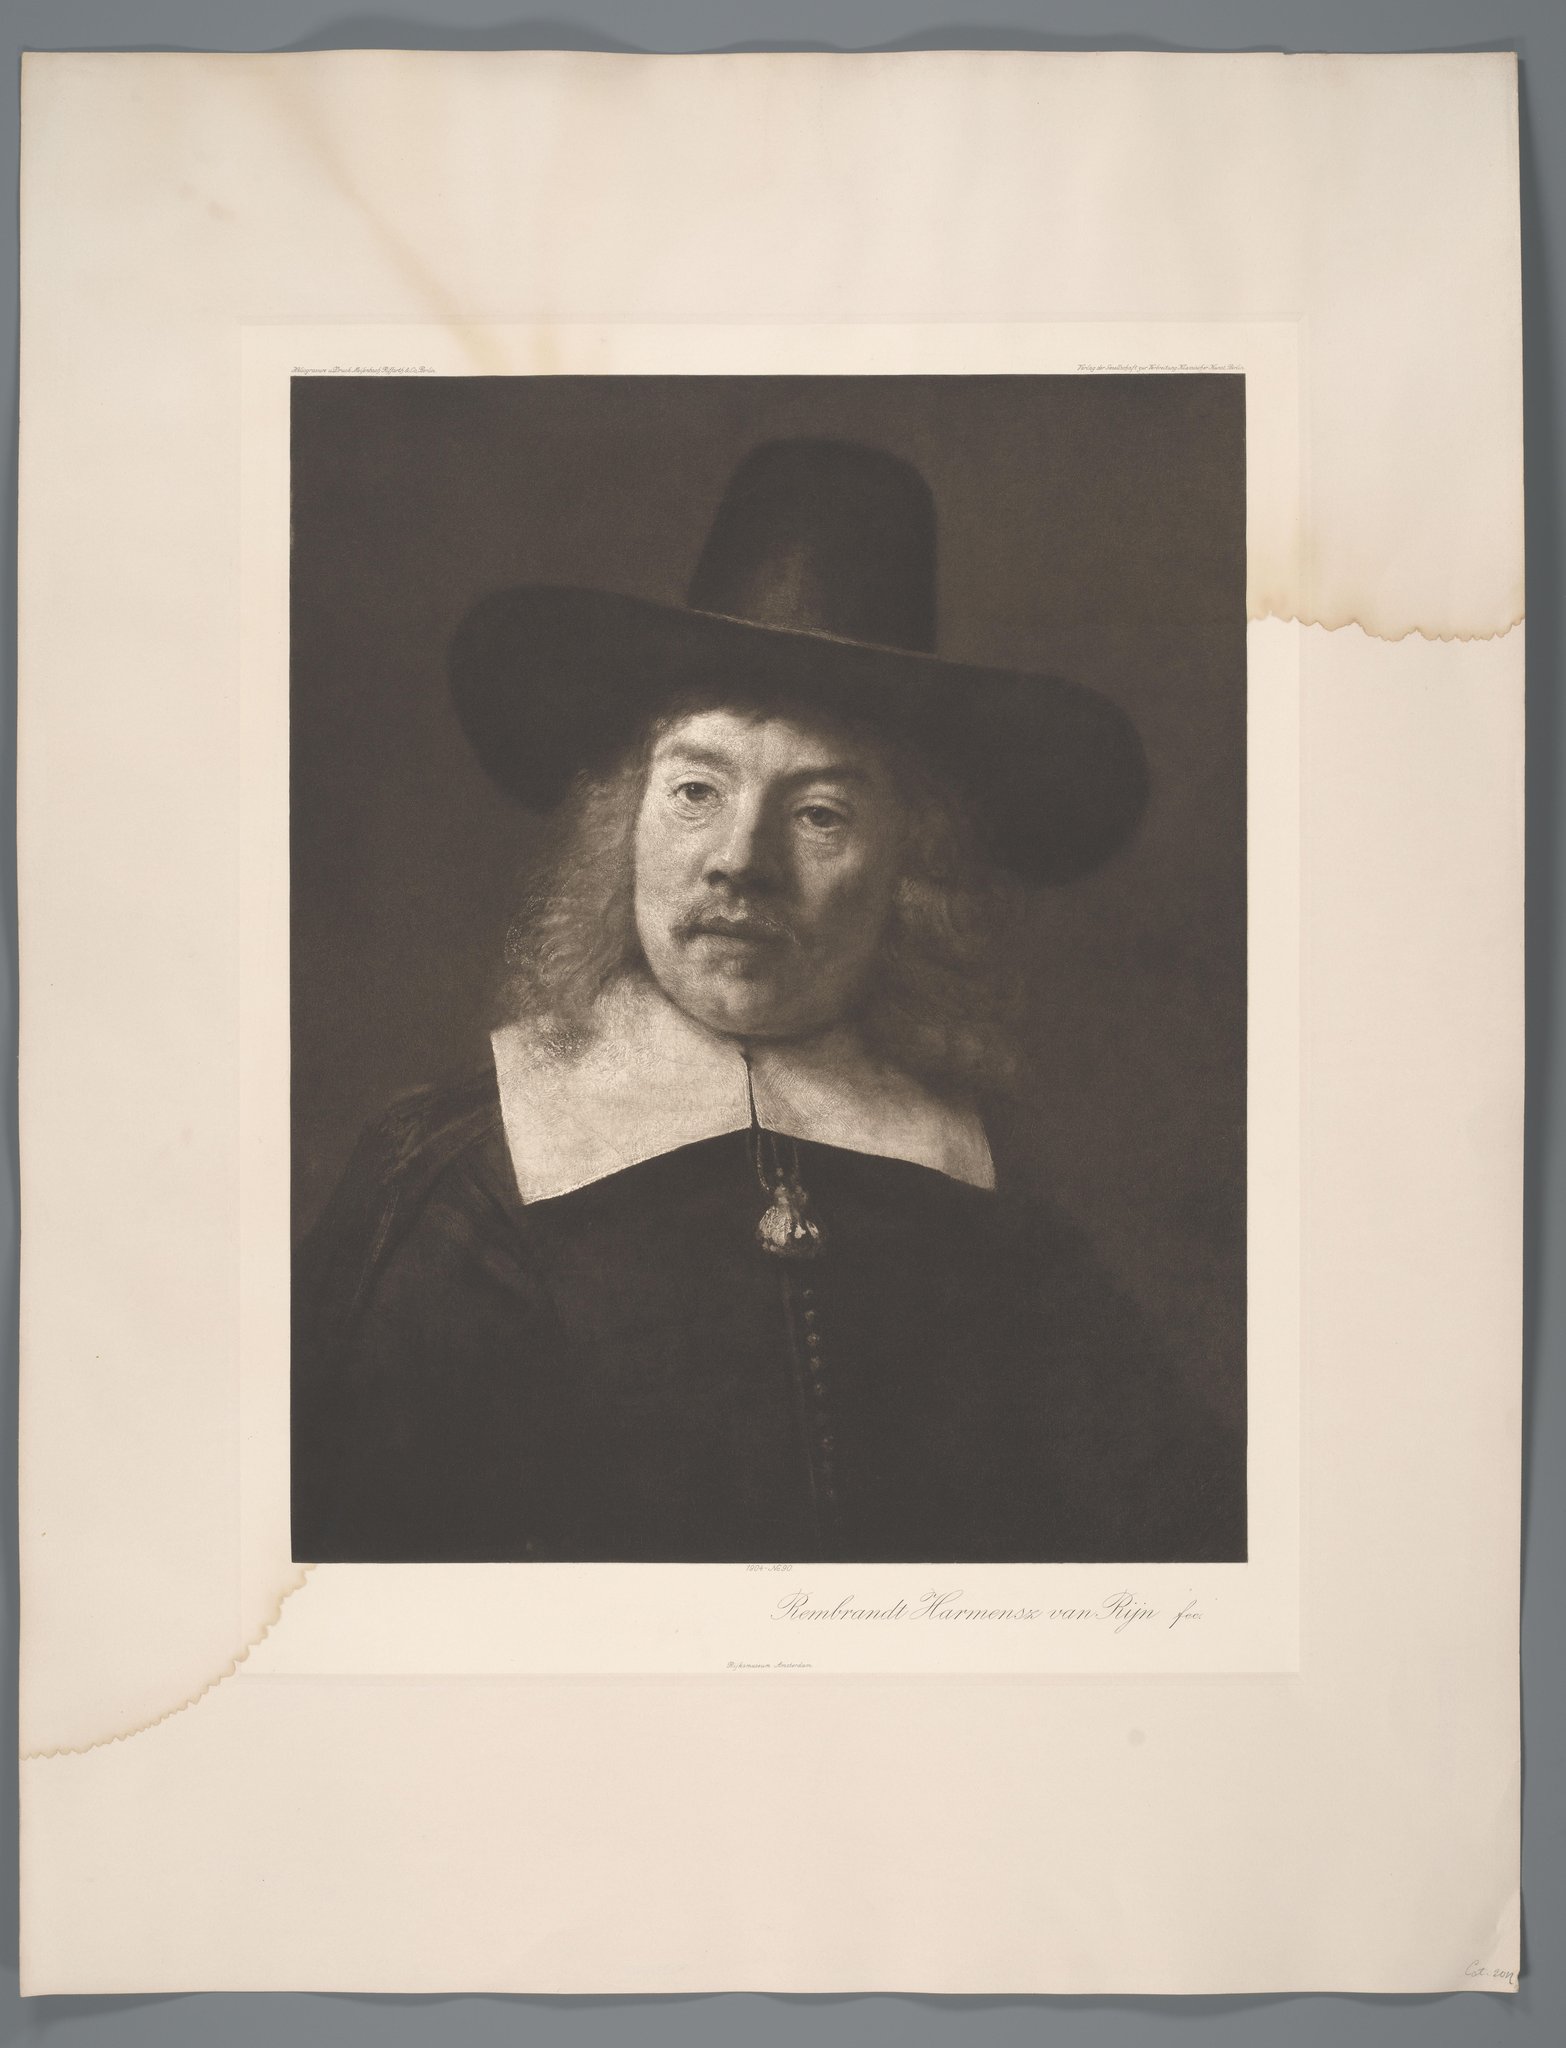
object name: reproduction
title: Fotoreproductie van een fragment van het schilderij De Staalmeesters door Rembrandt van Rijn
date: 1904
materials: cardboard, paper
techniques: photoaquatint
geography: berlin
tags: historical persons, picture, painting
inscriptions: inscription: ‘Verlag der Gesellschaft zur Verbreitung Klassischer Kunst. Berlin.’, inscription: ‘Rembrandt Harmensz van Rijn fec.’, inscription: ‘Heliogravure u. Druck Meisenbach Riffarth & Co, Berlin’, inscription: ‘1904 - No 90./ Rijksmuseum Amsterdam’